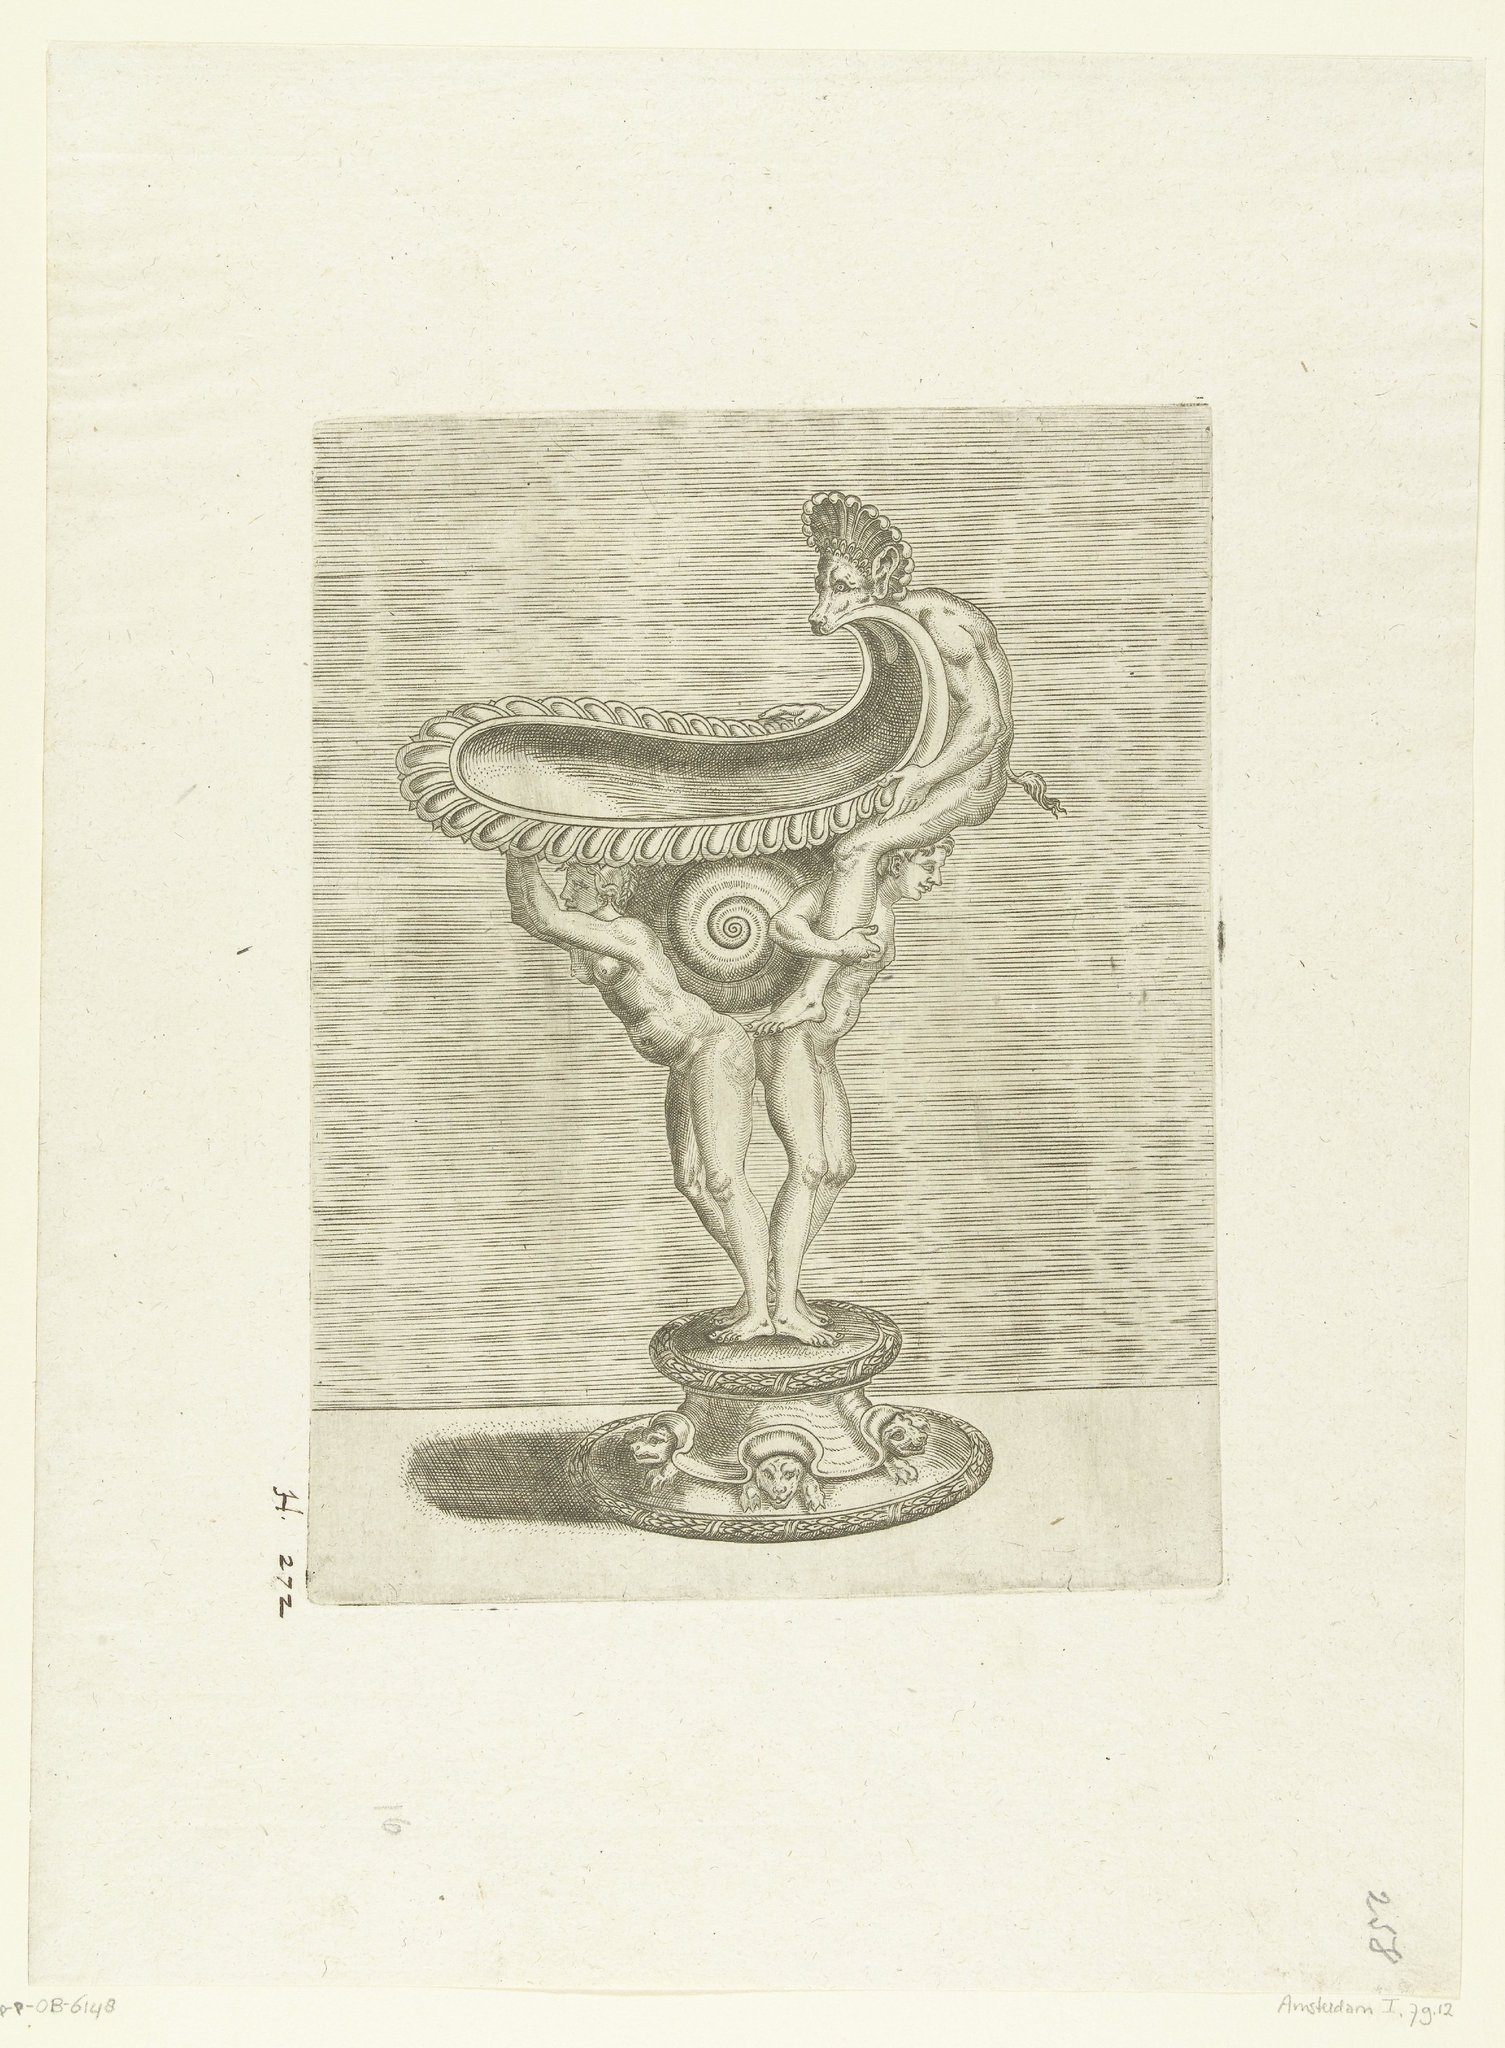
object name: ornament print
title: Vazen, kannen en schalen met grotesken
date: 1548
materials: paper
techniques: engraving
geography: netherlands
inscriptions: number: ‘H. 272’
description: De schaal rust op een slakkenhuis dat geklemd zit tussen de ruggen van een man en een vrouw. De vrouw steunt de schaal met haar handen. De man draagt de sater op zijn schouders. Afkomstig uit een serie bestaande uit een titelblad en 20 bladen.